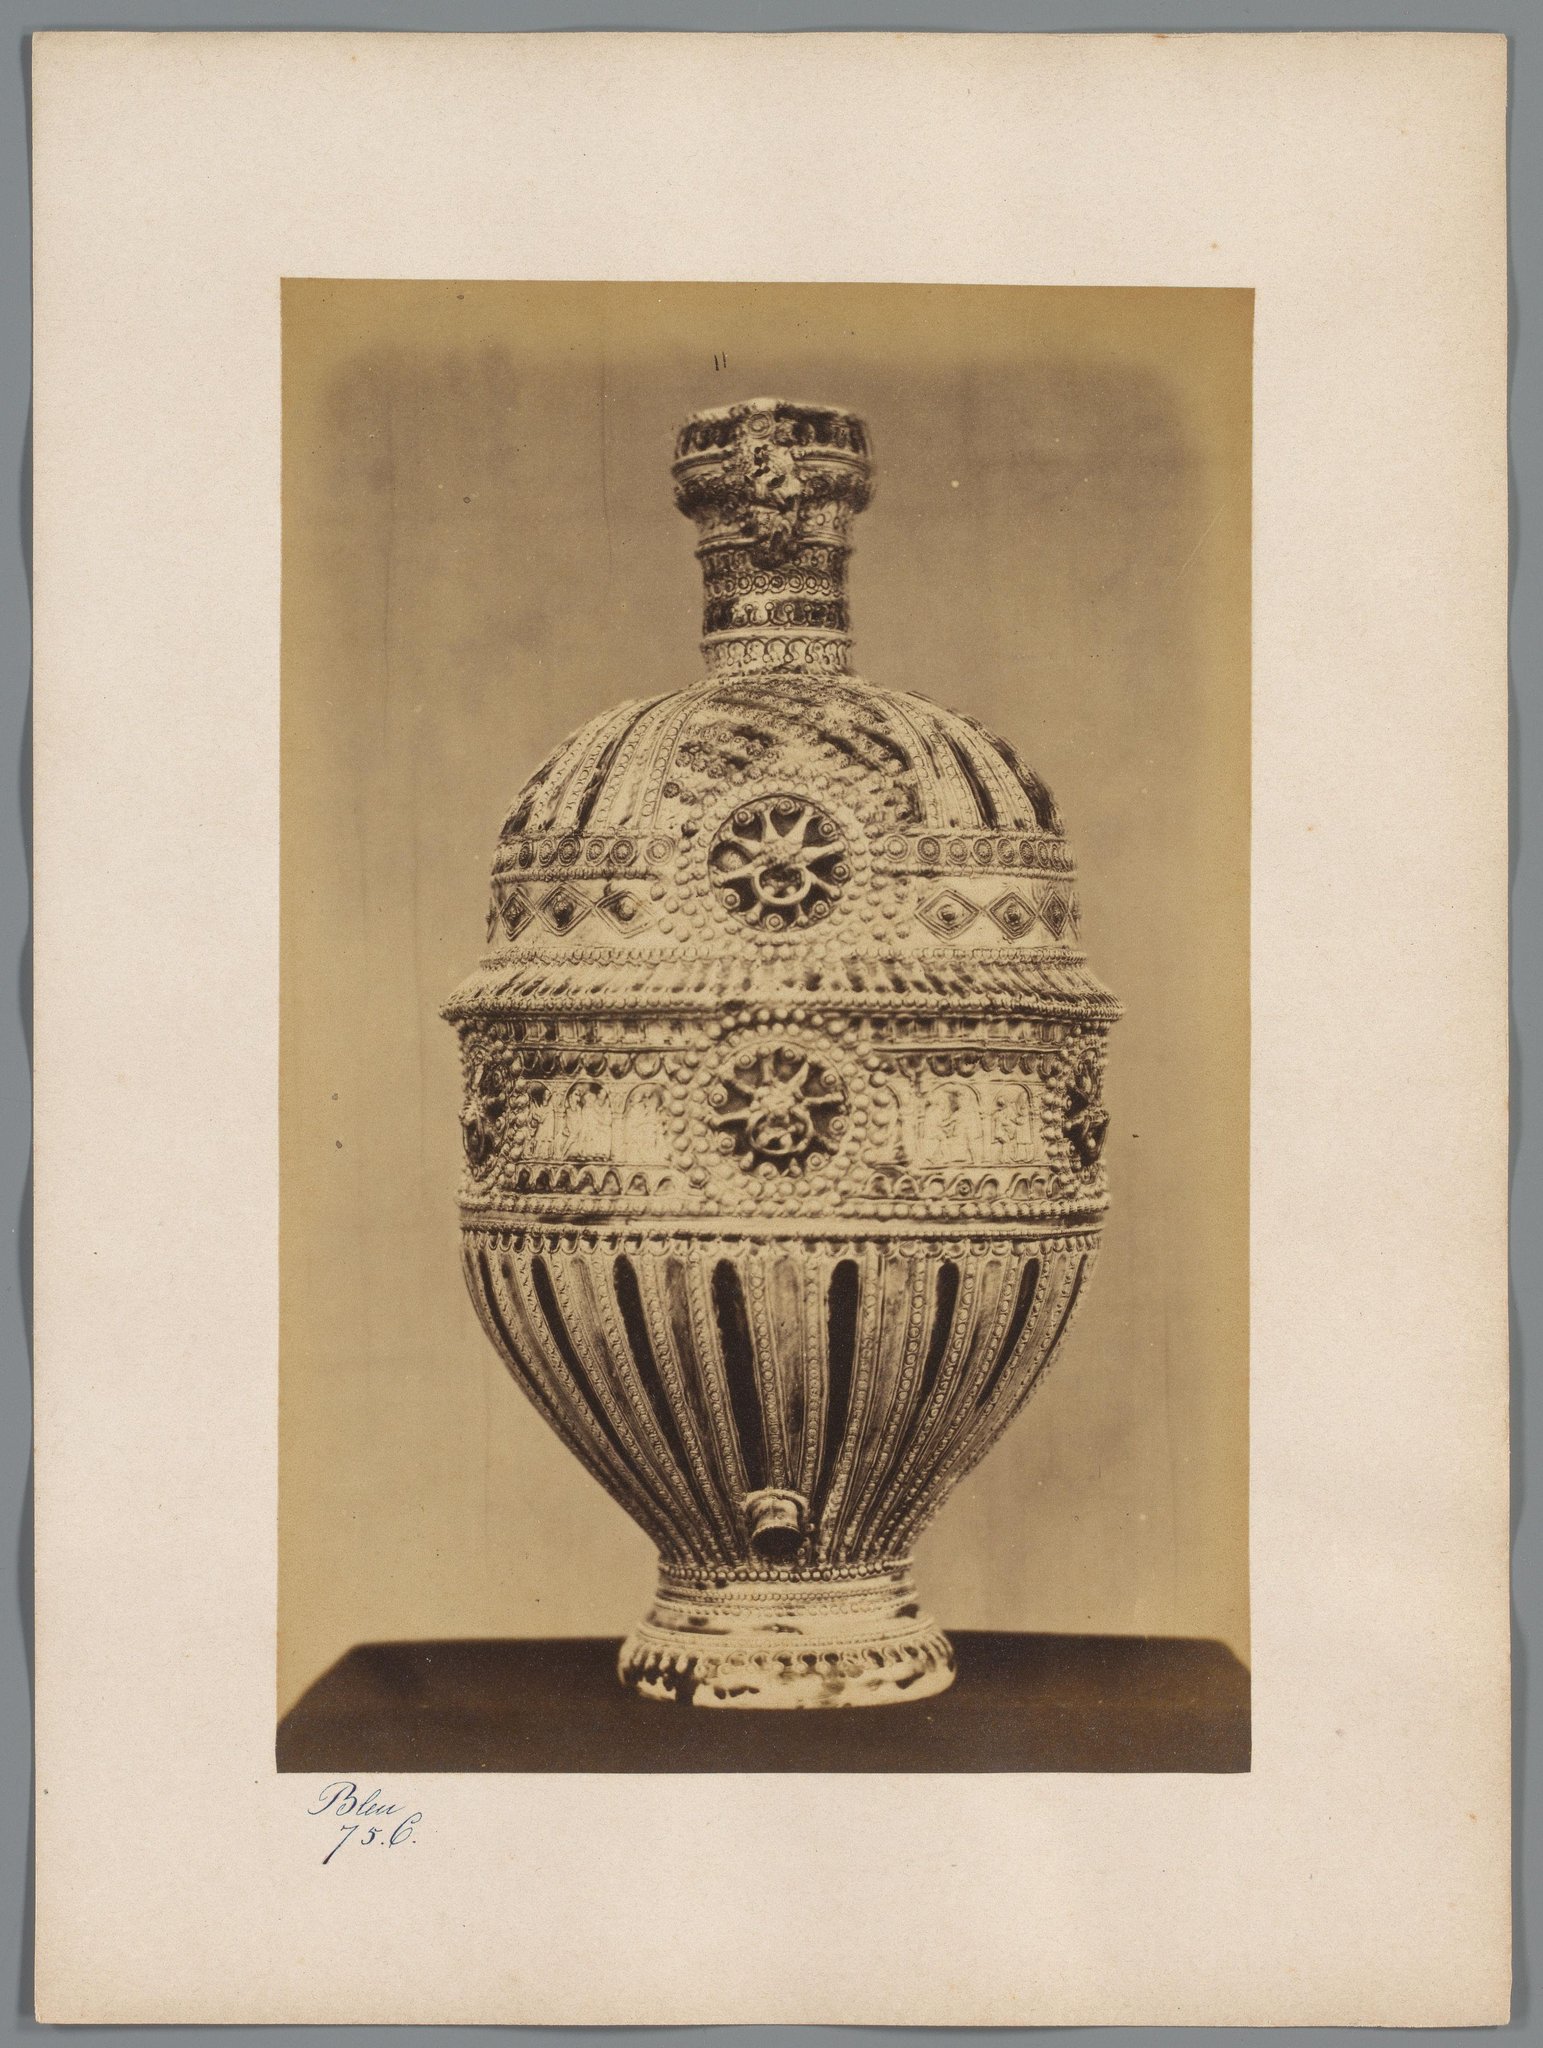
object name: photograph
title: Aardewerken vaas uit de collectie van W. de Weckherlin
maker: Anonymous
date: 1860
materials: paper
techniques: albumen print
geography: the hague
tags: container of ceramics: jar, jug, pot, vase, the hague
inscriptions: inscription: ‘Bleu/ 75G.’